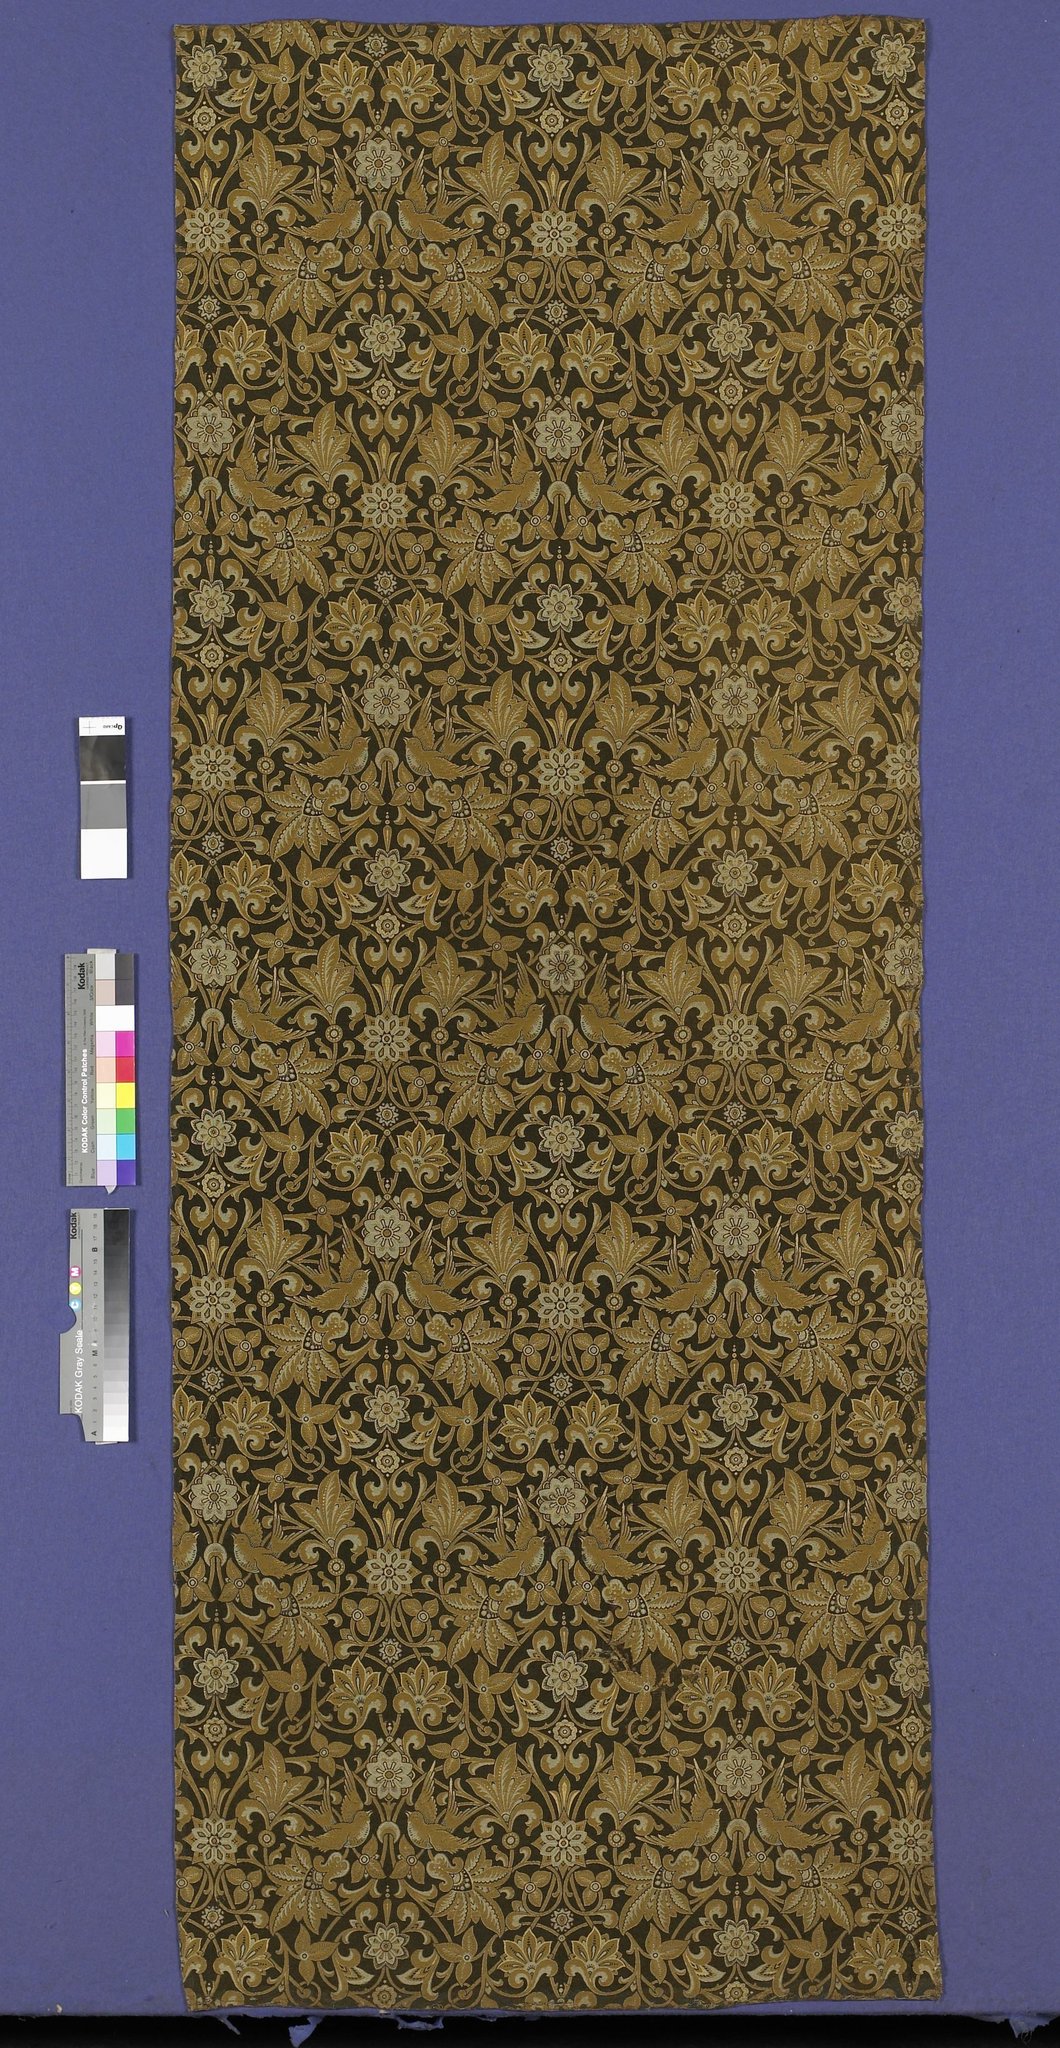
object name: woven material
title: Weefsel 'Chandos'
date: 1868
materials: cotton, silk, wool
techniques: weave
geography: spitalfields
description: Weefsel van zijde, katoen en wol, met een verspringend patroon van vogels en passiebloemen gevat in spitsovalen.